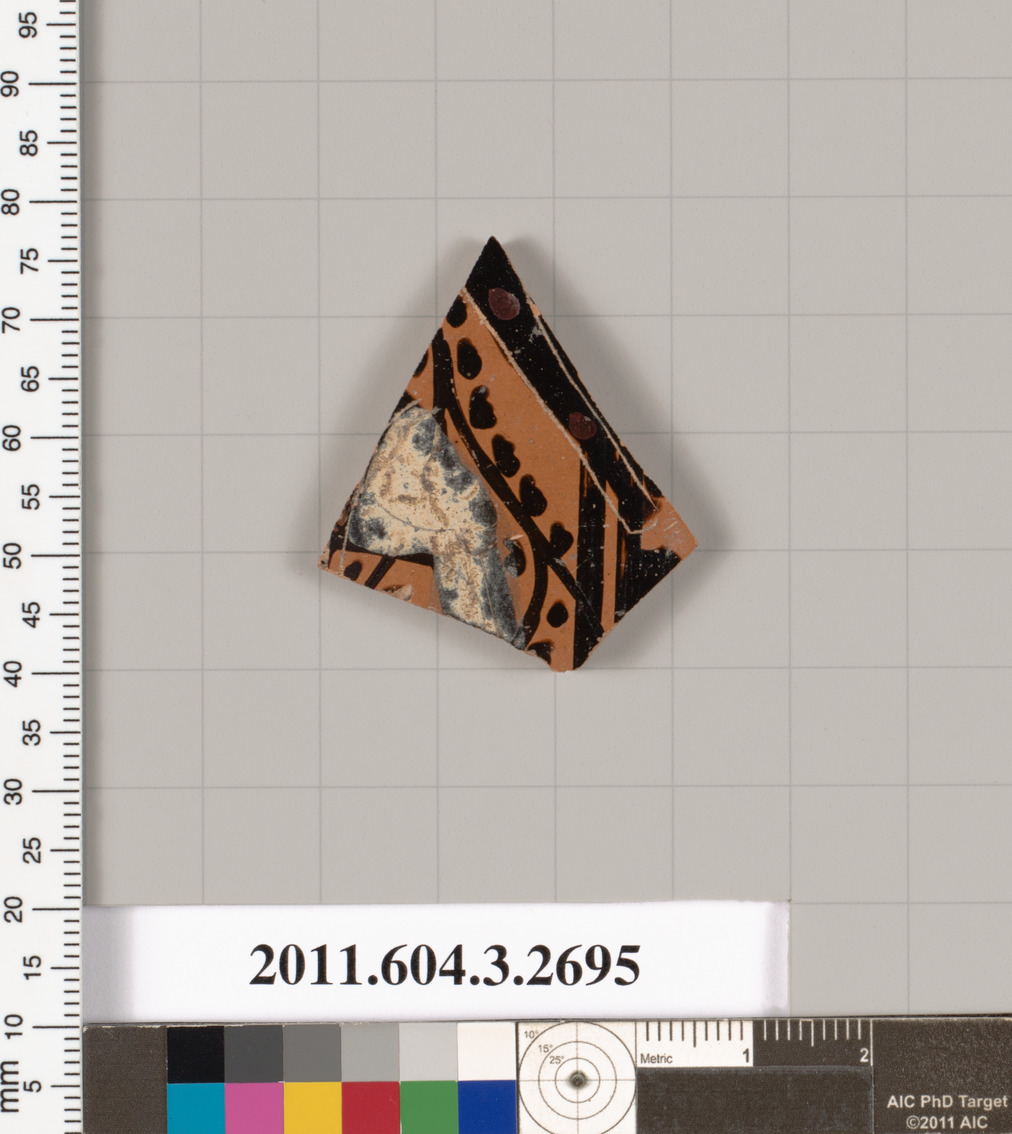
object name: oinochoe or olpe fragment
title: Terracotta fragment of an oinochoe (jug) or olpe (jug)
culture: greek, attic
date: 510-500 BCE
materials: terracotta